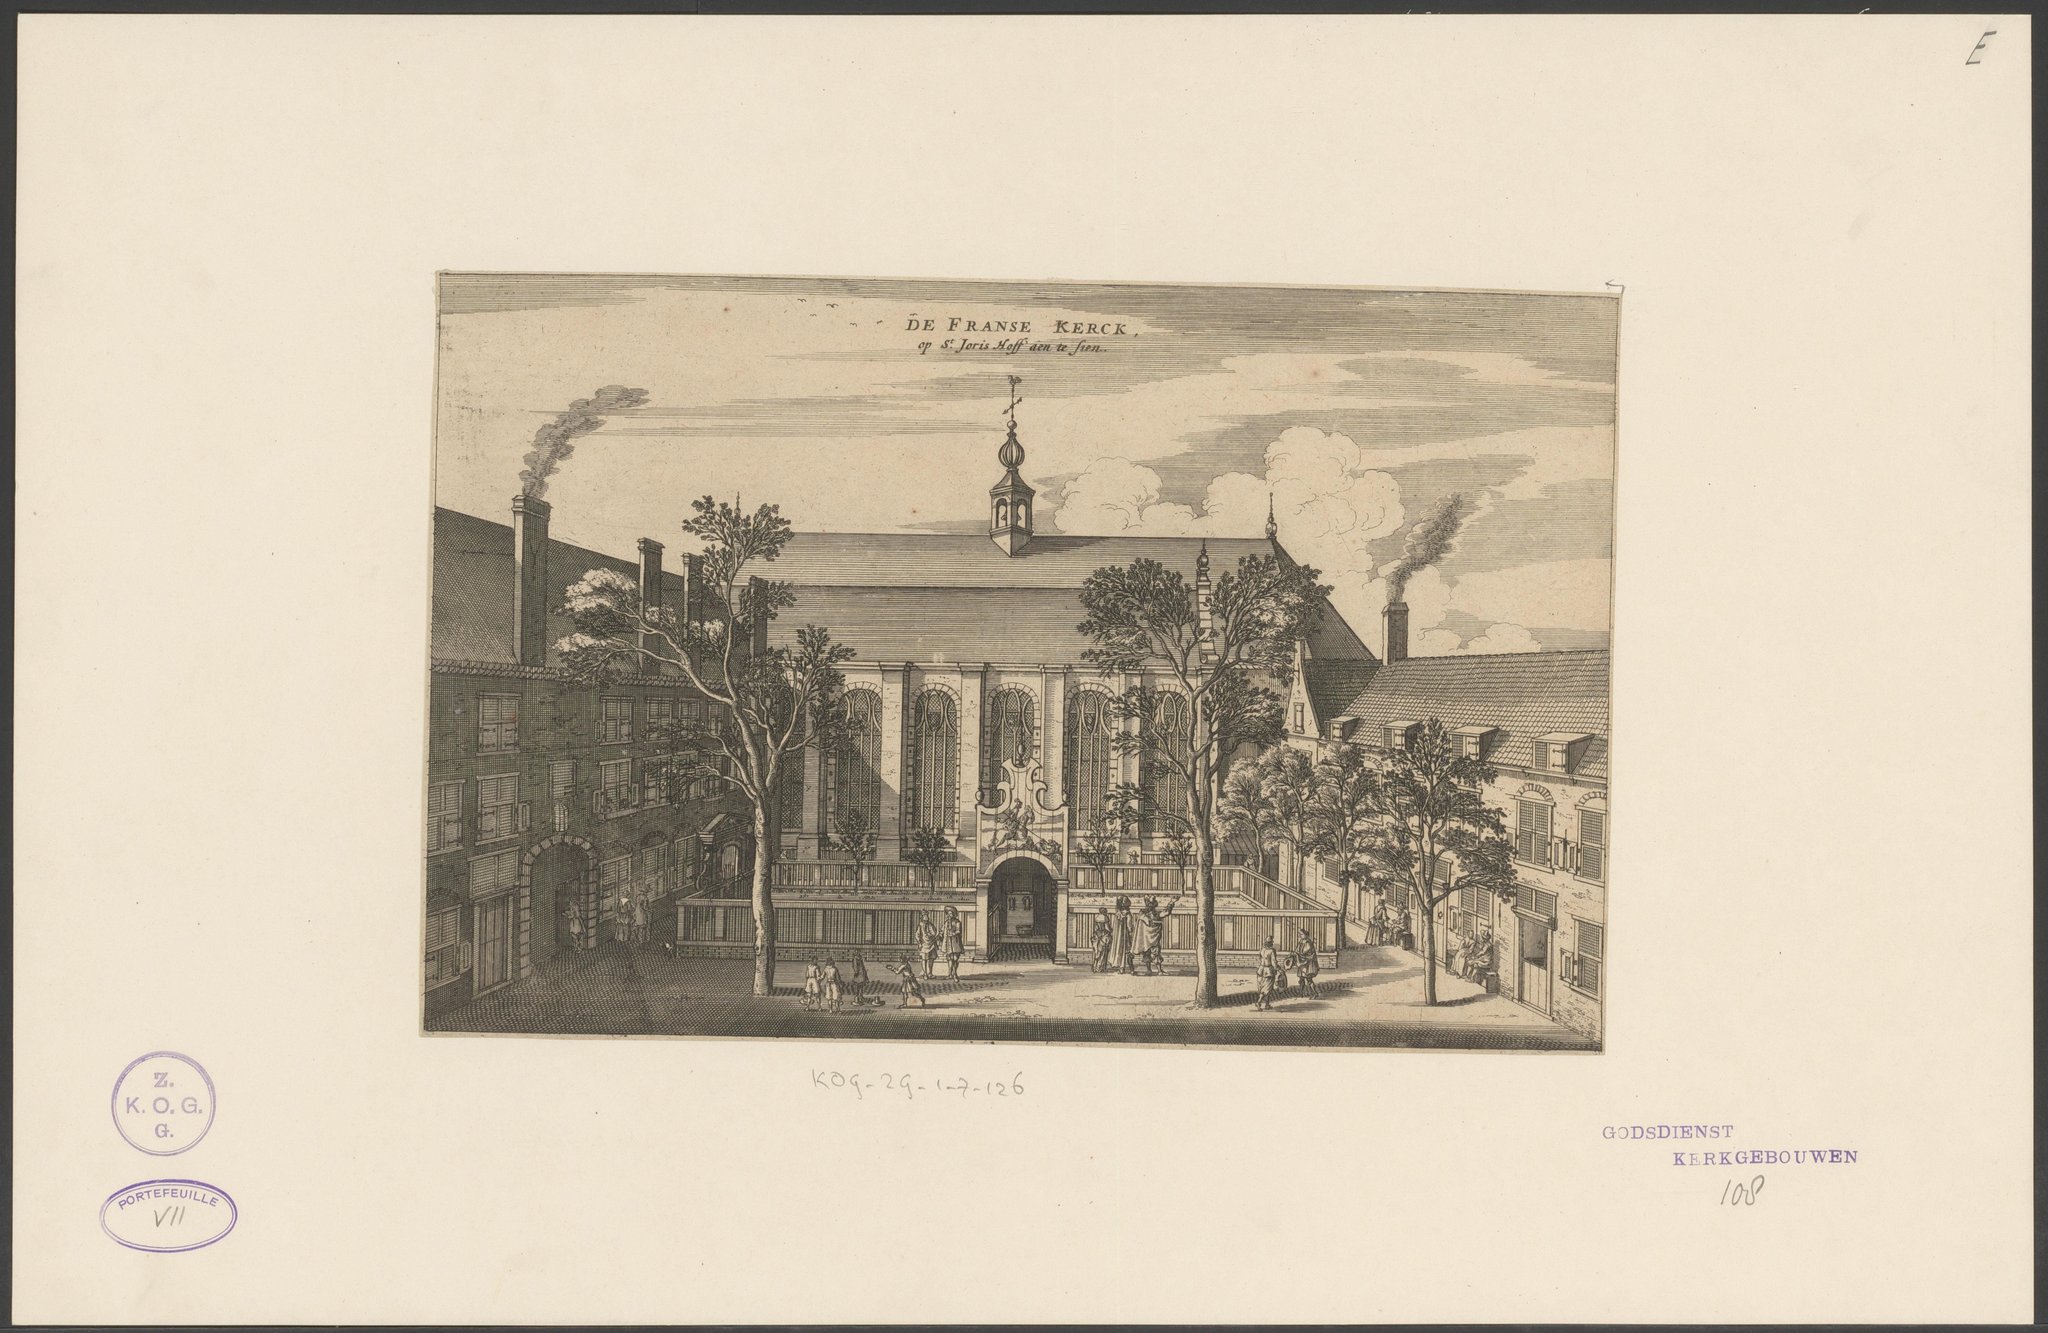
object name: print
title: De Franse Kerck op St. Joris Hoff aen te sien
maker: jacob van meurs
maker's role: draughtsman, print maker, publisher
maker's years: 1619-1680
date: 1663-1664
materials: paper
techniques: etching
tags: alms-house (dutch: 'hofje'), church (exterior), courtyard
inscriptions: stamp, stamp, collector's mark: Lugt 1641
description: Prent mogelijk uit: Dapper, Olfert. Historische beschryving der stadt Amsterdam: waer in de voornaemste geschiedenissen (na een kort verhael van gansch Hollant en d'omleggende dorpen (…). Amsterdam: Jacob van Meurs, 1663. En in: Zesen, Philipp von. Beschreibung der Stadt Amsterdam: darinnen von derselben ersten Ursprunge bis auf gegenwärtigen Zustand (…). Amsterdam: Joachim Nosche, 1664. In sommige exemplaren van deze uitgave komt de huidige staat van de prent voor. In andere exemplaren is een latere staat ingebonden, waarop boven de Nederlandse een Franse titel is toegevoegd.